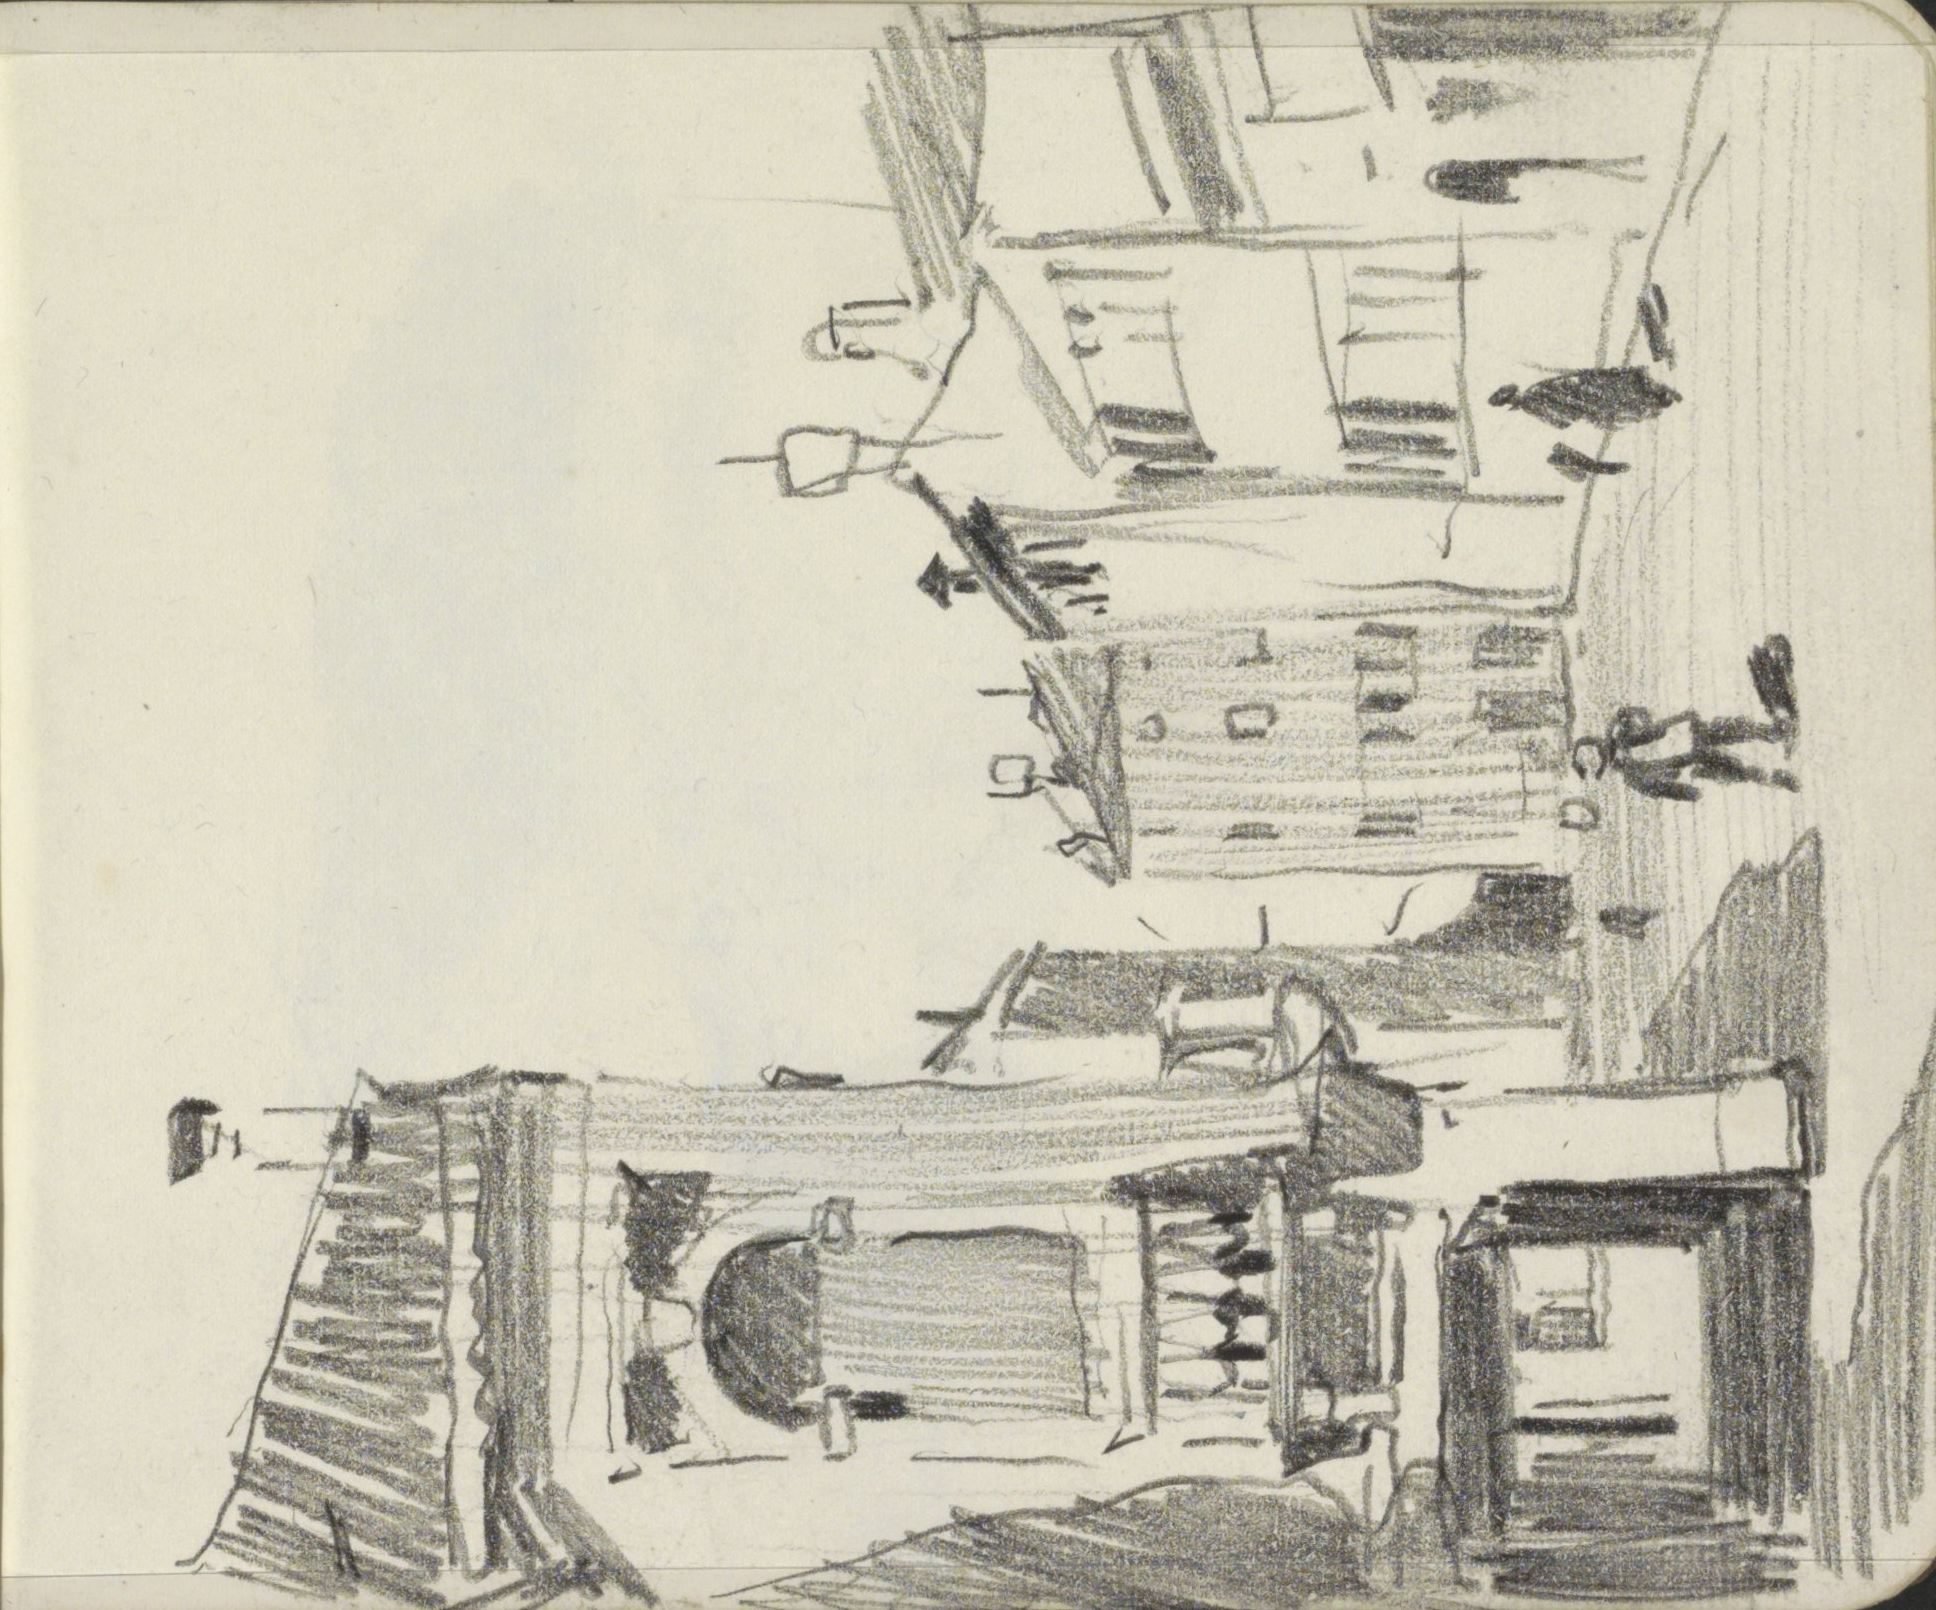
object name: sketchbook leaf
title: Gezicht op een straat of plein in Venetië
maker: willem witsen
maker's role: draughtsman, painter, print maker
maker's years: 1860-1923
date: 1914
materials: paper, pencil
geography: venice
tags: civic architecture; edifices; dwellings, square, place, circus, etc. (+ city(-scape) with figures, staffage), street (+ city(-scape) with figures, staffage), venice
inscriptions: watermark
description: Pagina 45 uit een schetsboek met 26 bladen.